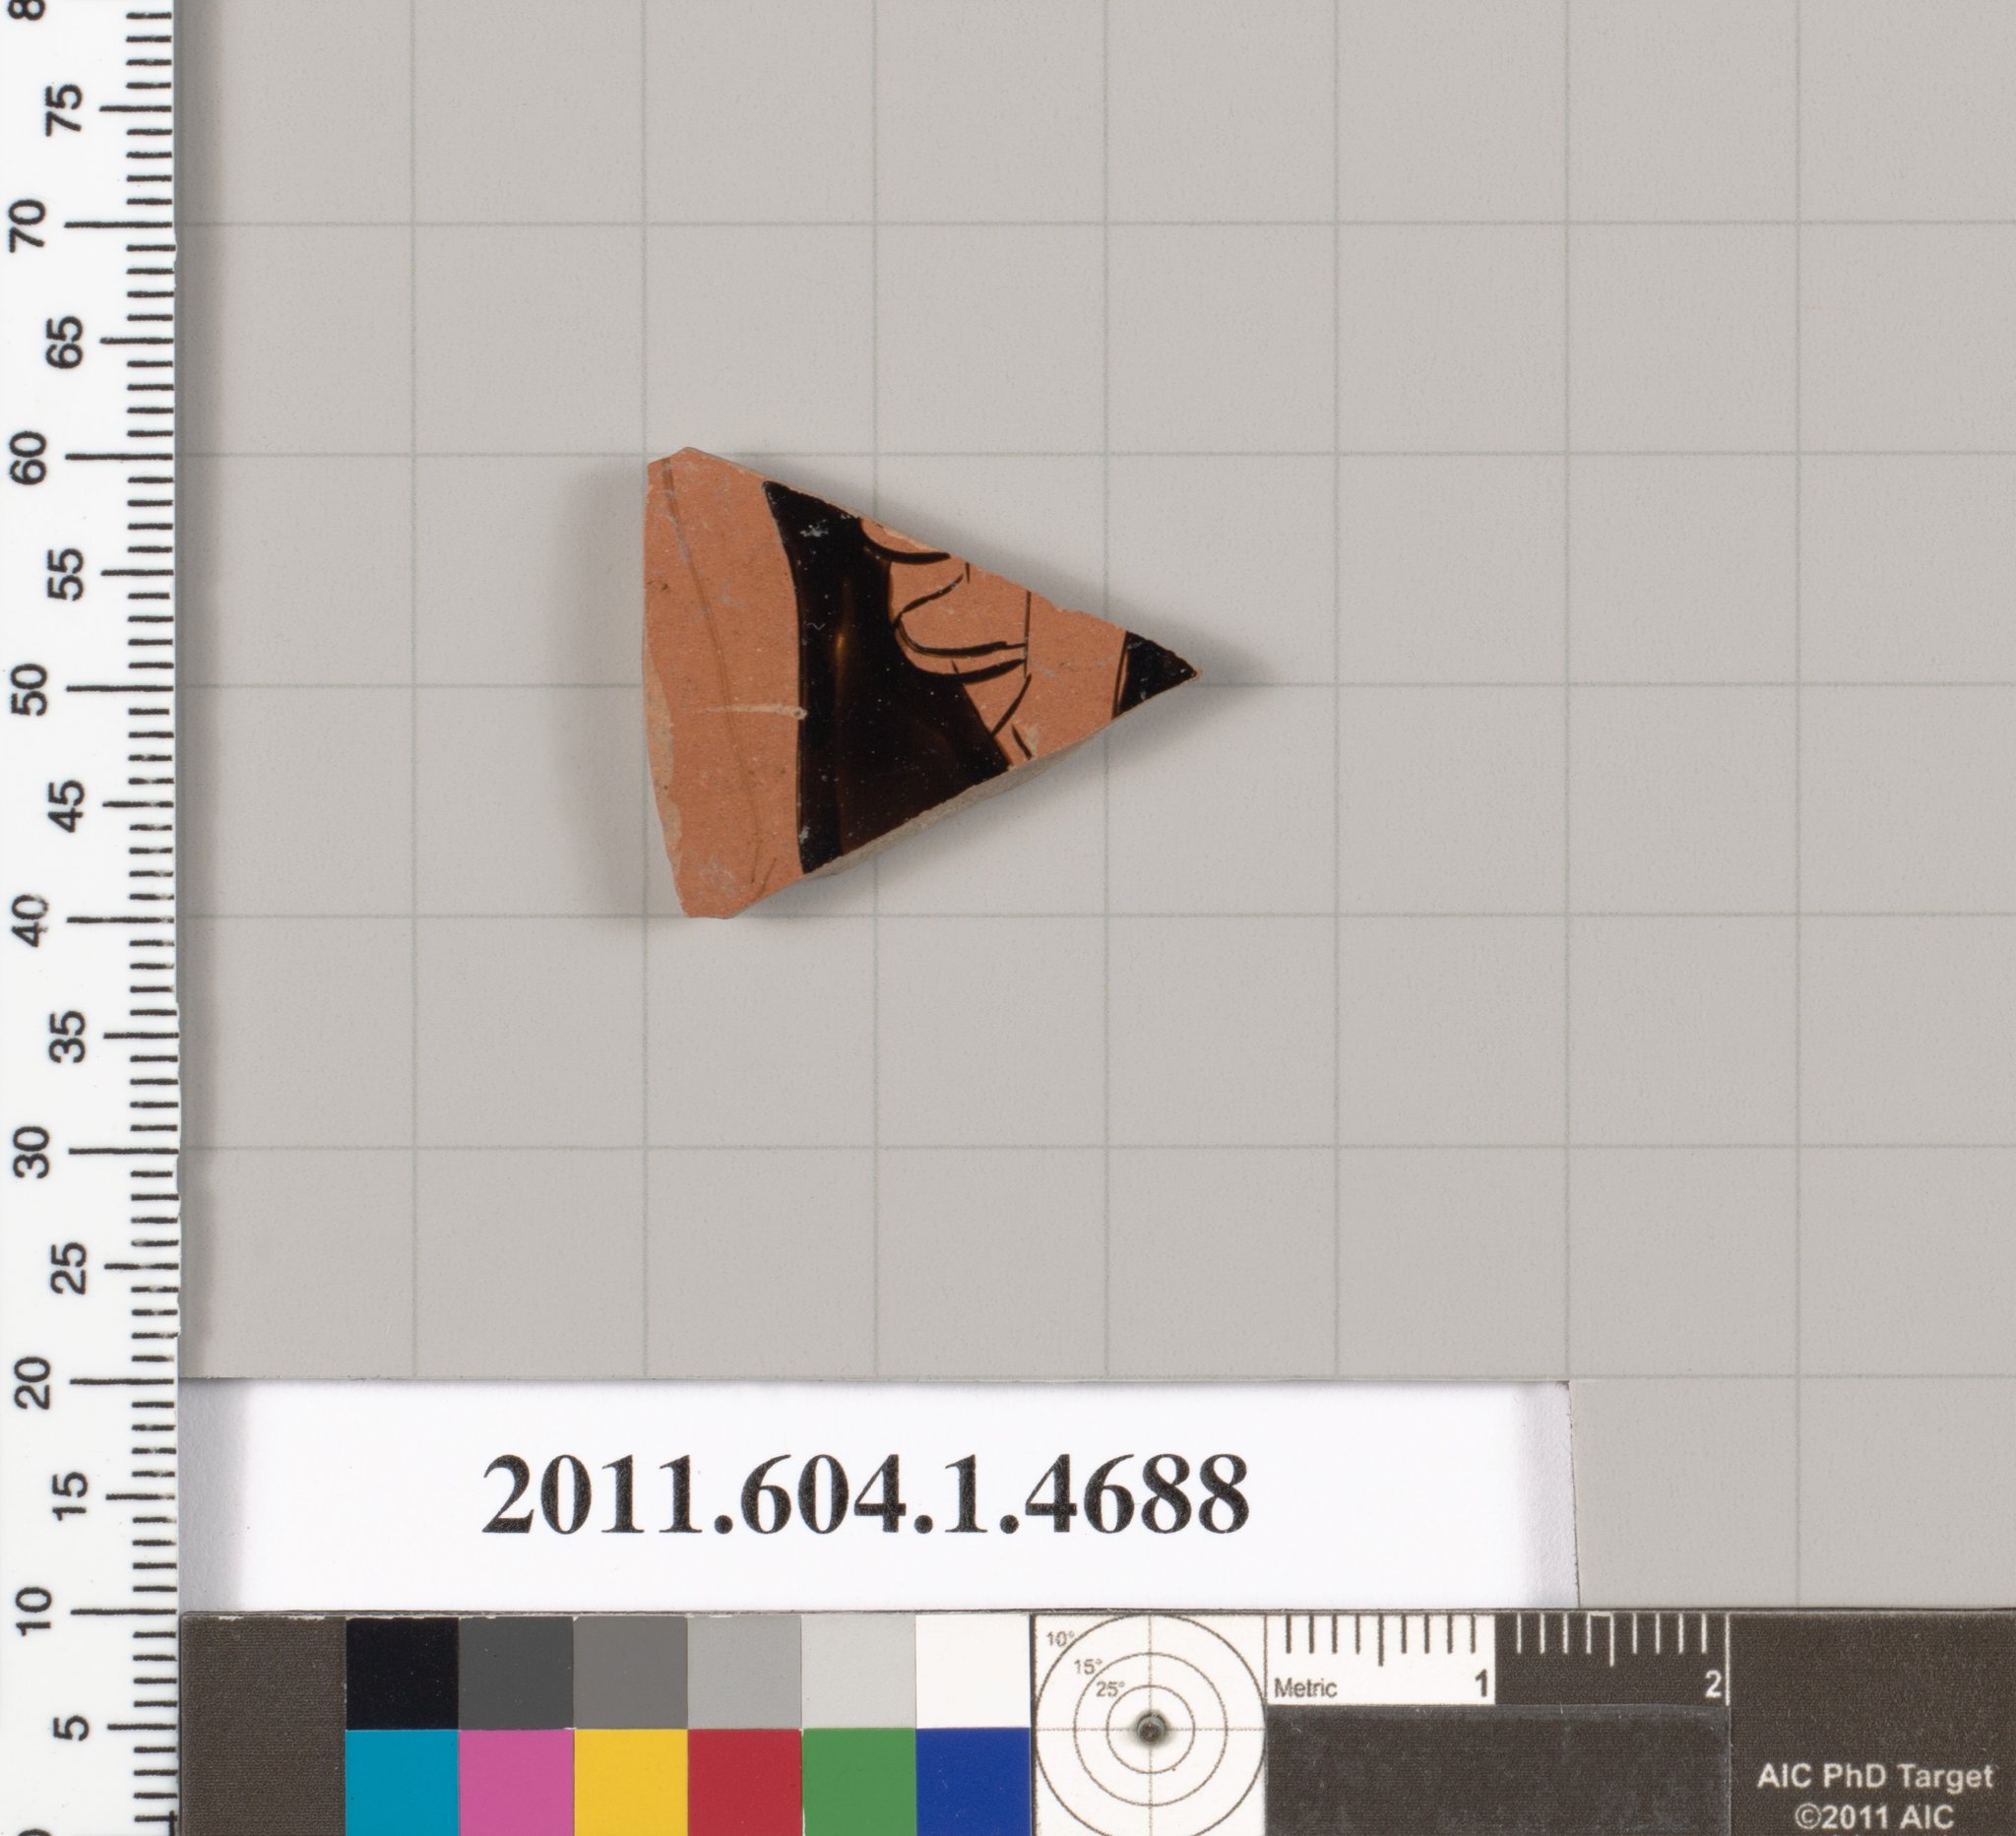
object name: kylix fragment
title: Terracotta fragment of a kylix (drinking cup)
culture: greek, attic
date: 490-470 BCE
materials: terracotta